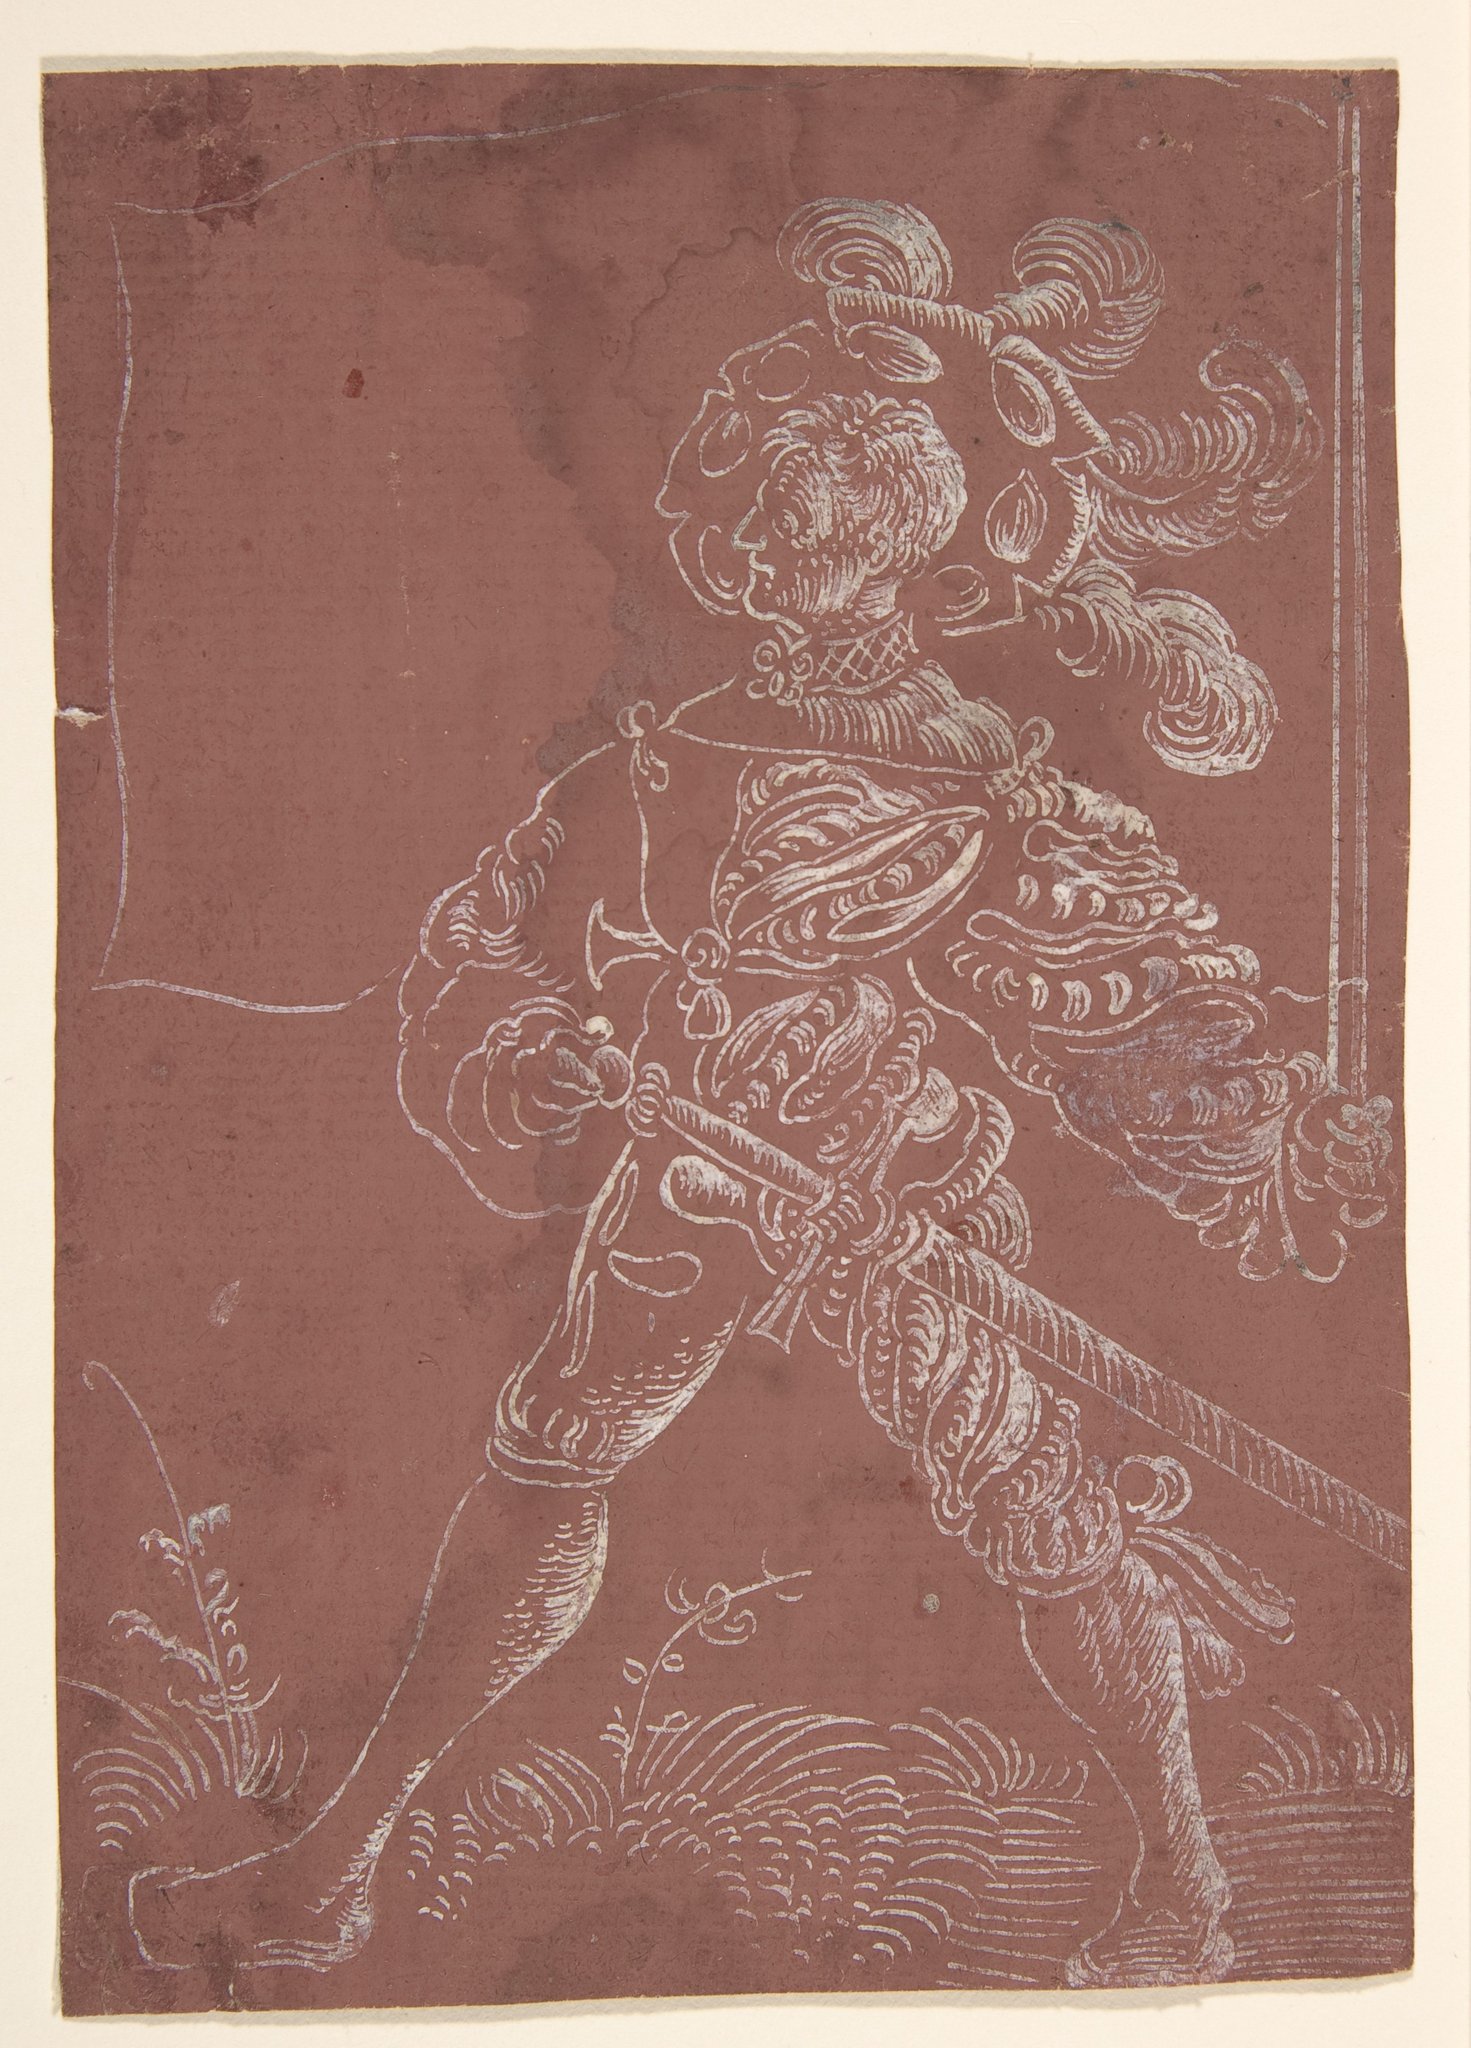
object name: drawing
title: Standard Bearer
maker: urs graf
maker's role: artist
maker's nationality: swiss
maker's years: 1485-1527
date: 1500-1530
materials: gouache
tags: swords,men